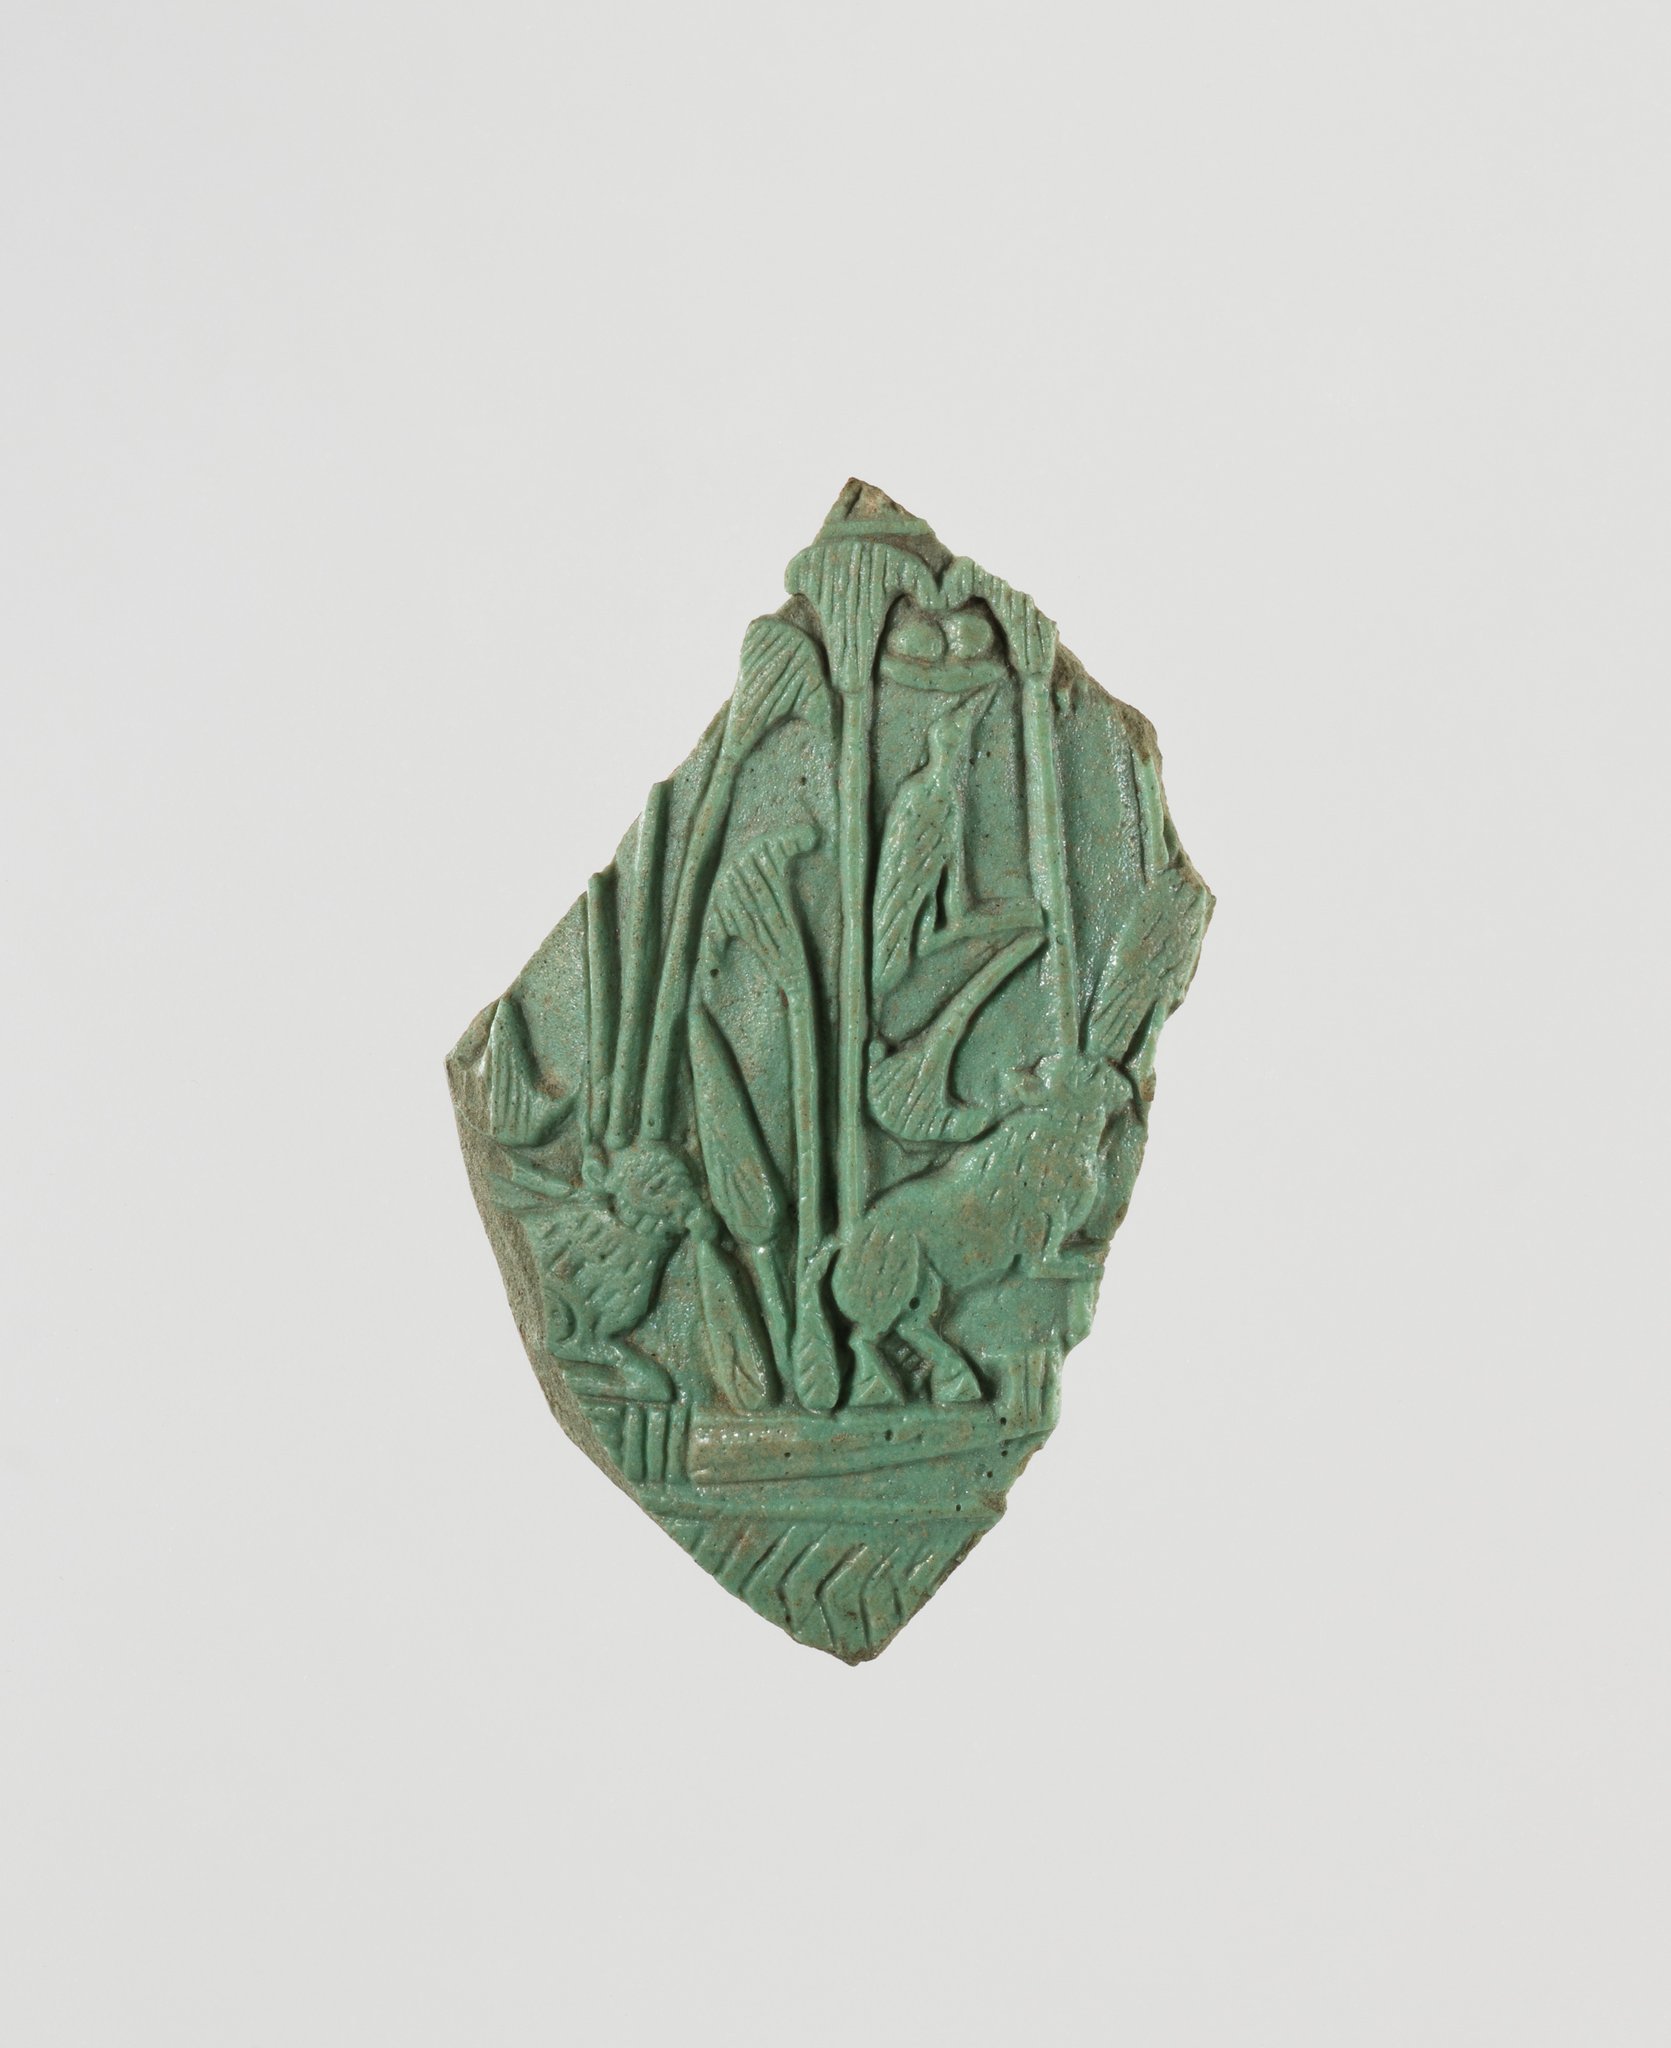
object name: flask fragment, chalice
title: Fragment of an ovoid flask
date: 1070-664 BCE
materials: faience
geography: egypt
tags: animals,birds